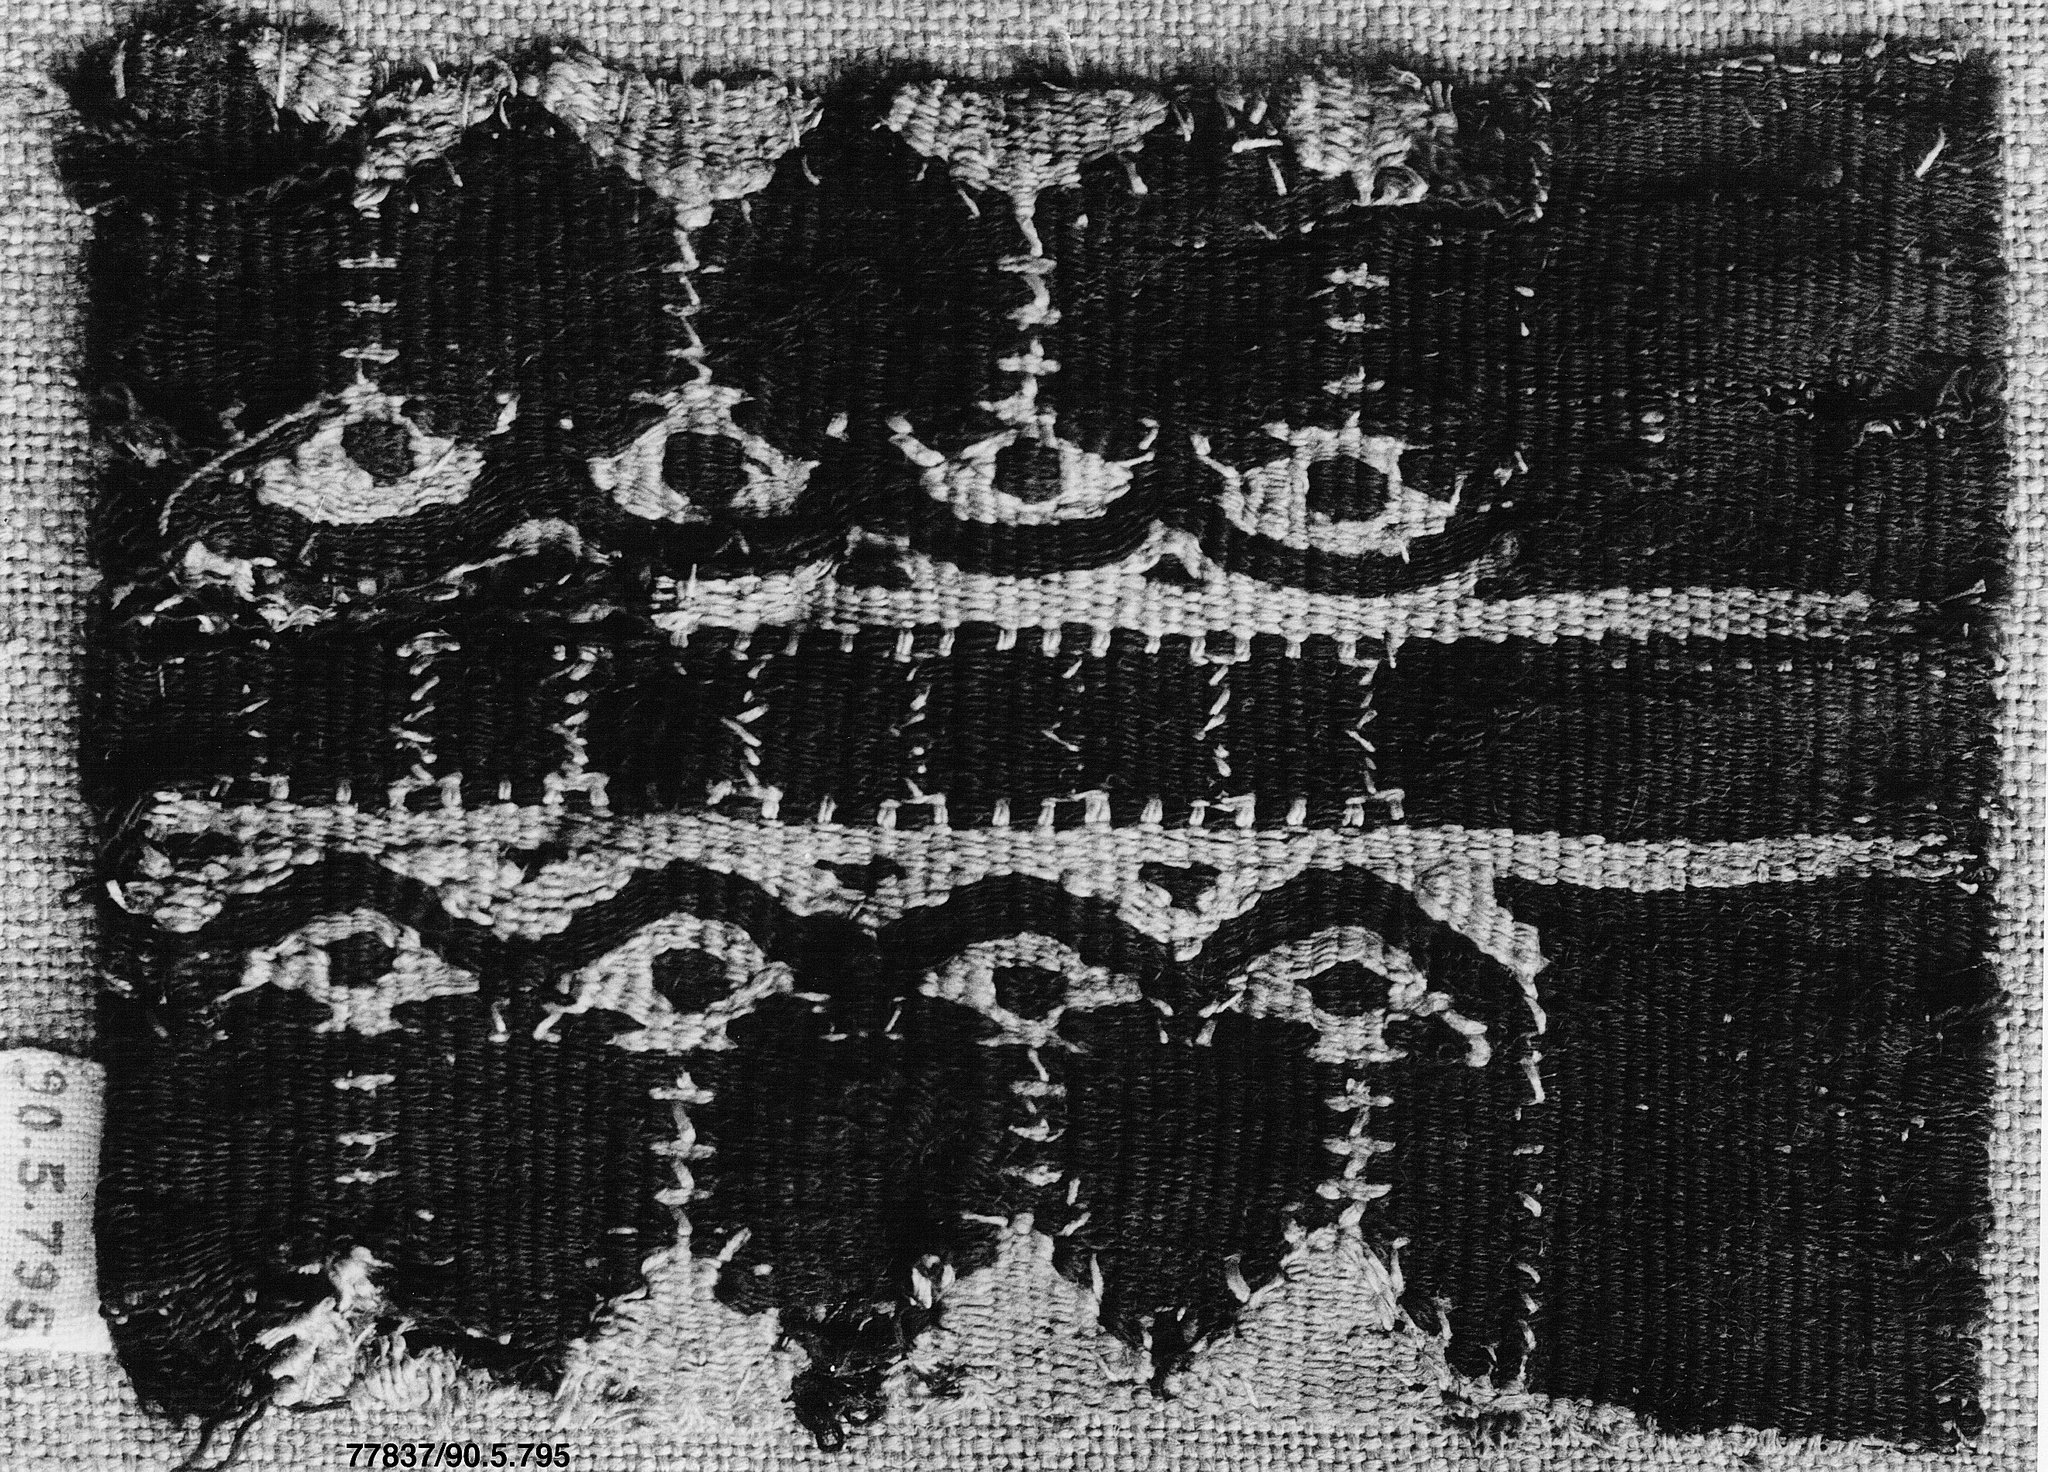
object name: textile fragment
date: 201-400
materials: linen, wool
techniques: weave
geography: egypt